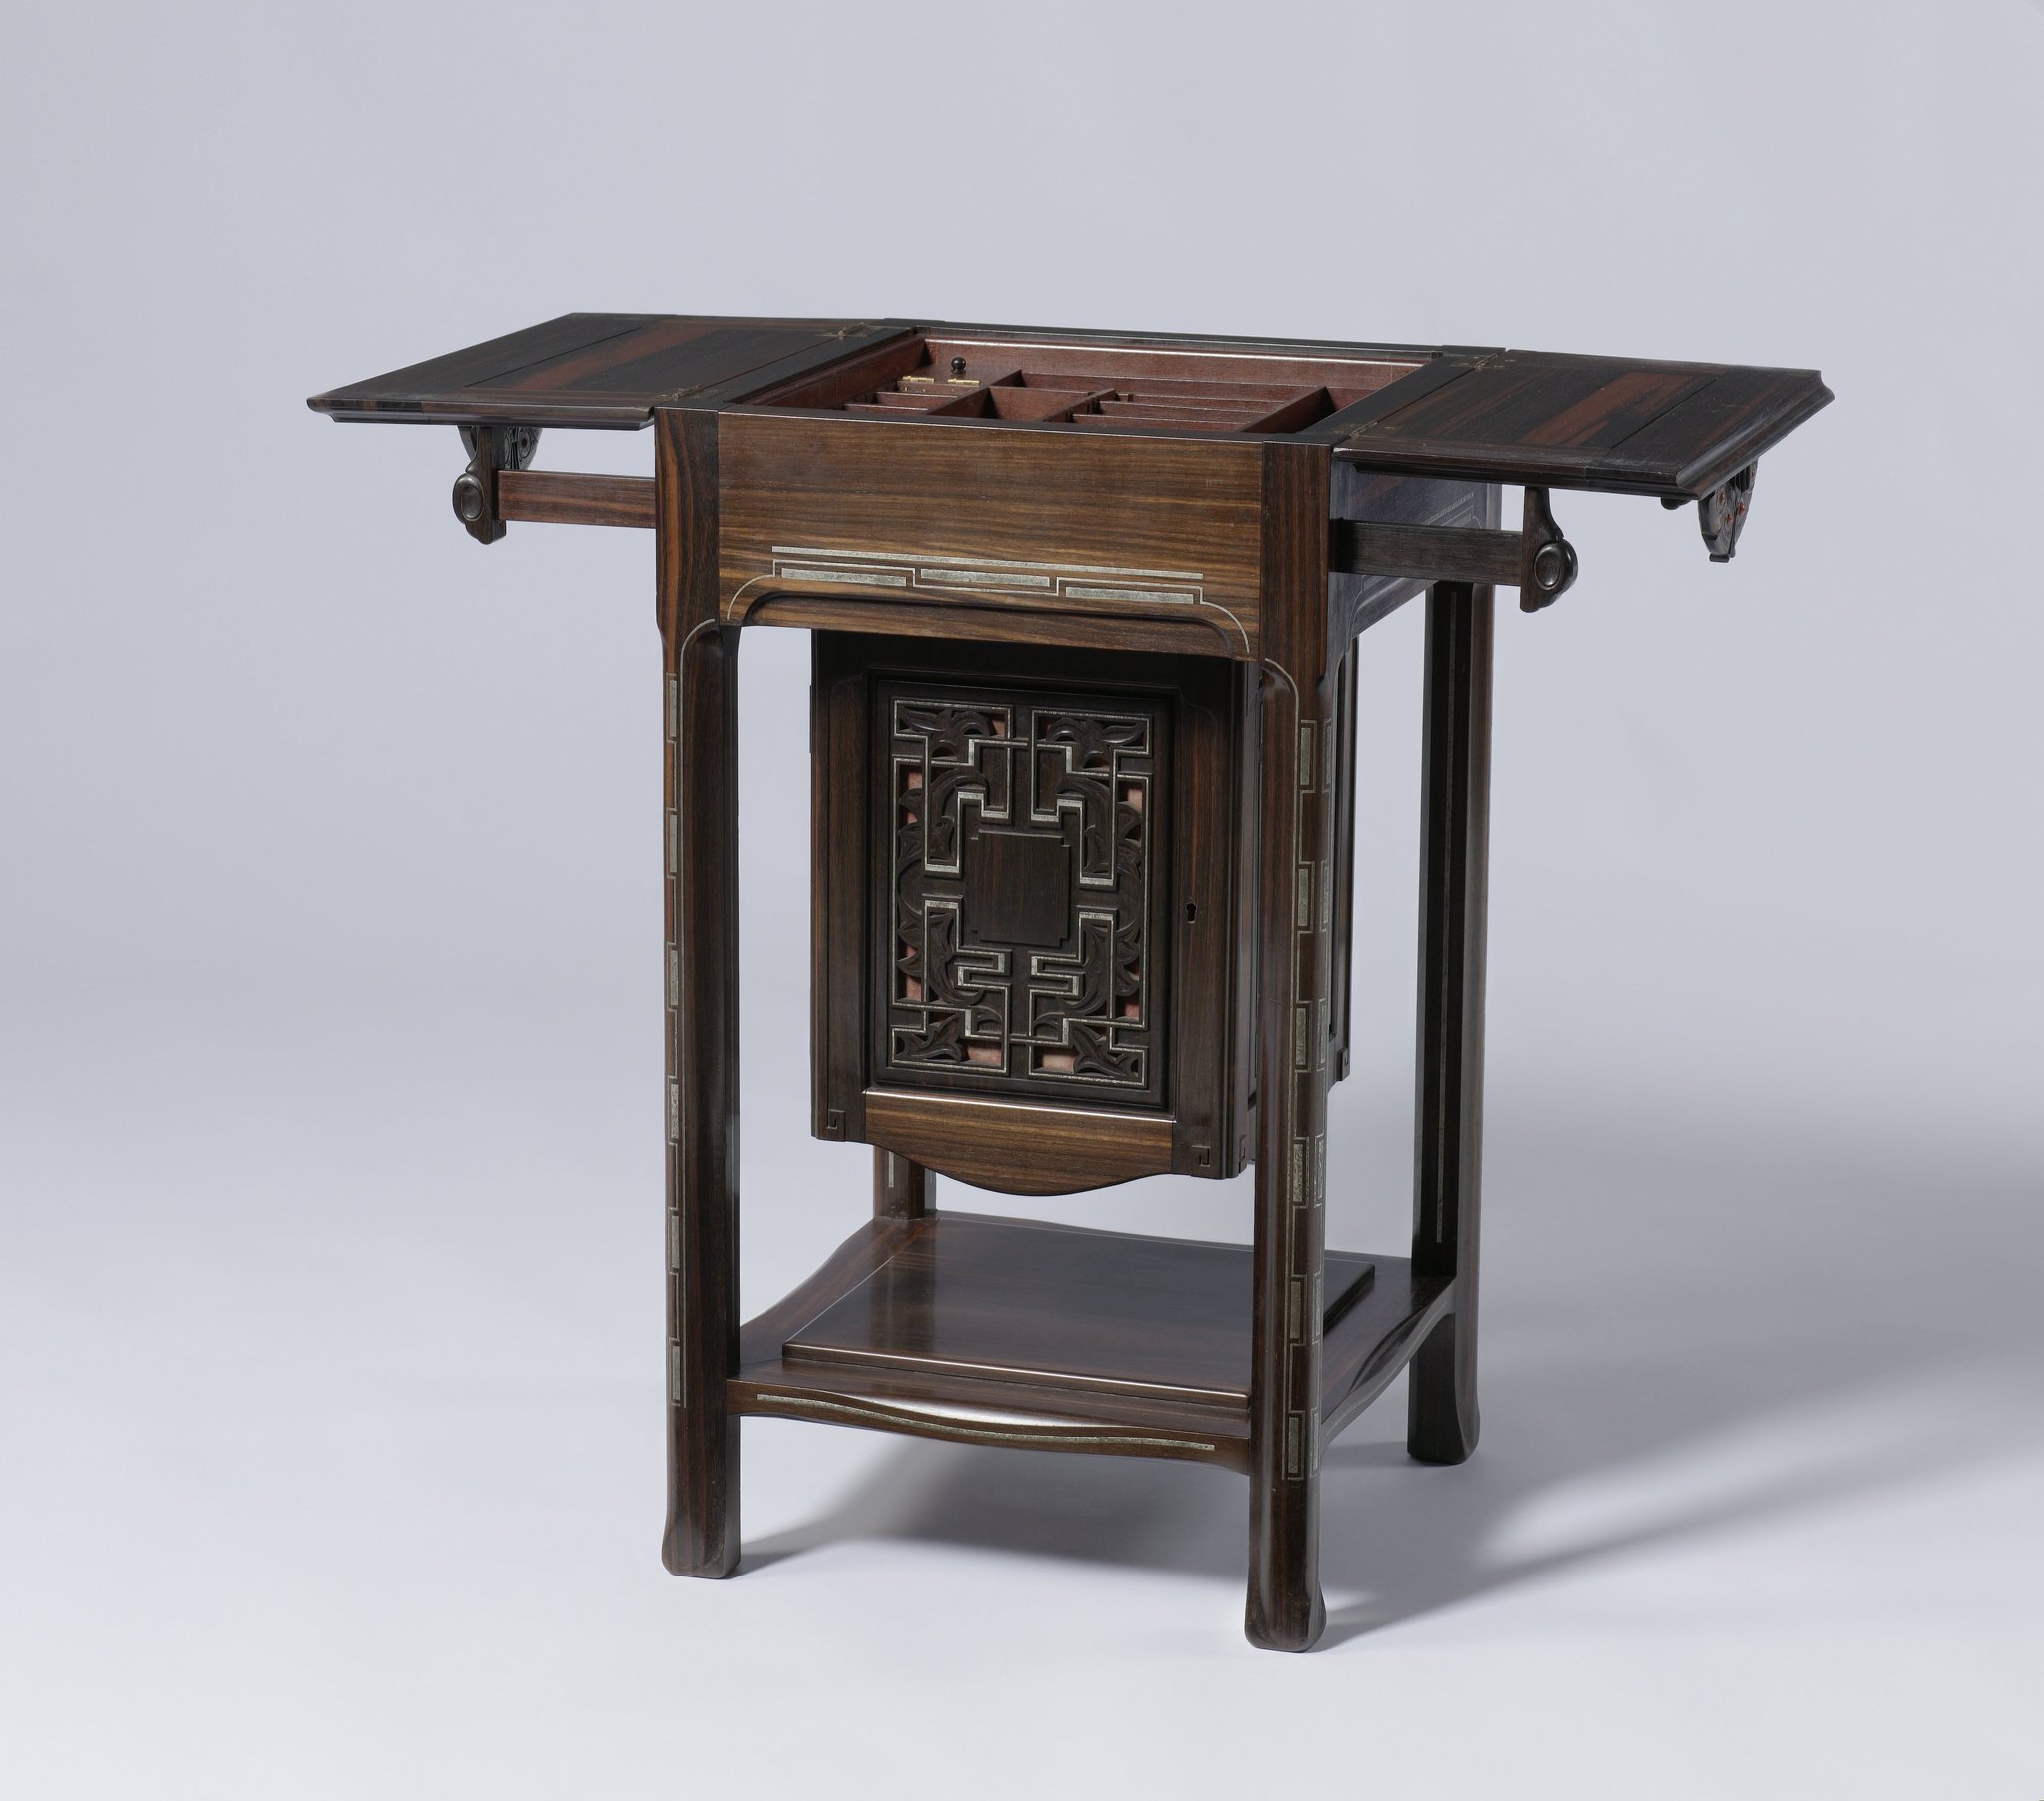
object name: sewing table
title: Naaitafel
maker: anton fortuin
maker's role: sculptor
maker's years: 1880-1967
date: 1929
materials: wood, leather, coral, tin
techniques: inlay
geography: amsterdam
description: Naaitafel van coromandelhout met tin, bloedkoraal, mahoniehout, rood leer en gebeitst eikenhout. De geprofileerde poten zijn, net als de tafelregels, ingelegd met tinnen strippen in een geometrisch patroon, en onderaan verbonden door een blad. Het tafelblad bestaat uit twee deksels met een bloedkoralen cabochon, snijwerk in reliëf, inlegwerk in tin en heeft twee vlinders met bloedkoralen cabochons als grepen. Onder het blad bevindt zich een kastje met gewelfde onderregel en opengewerkte zijden met rood leer.